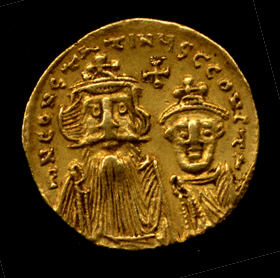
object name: solidus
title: Gold Solidus of Constans II (641–68)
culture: early byzantine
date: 654-659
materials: gold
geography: constantinople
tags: emperors,men